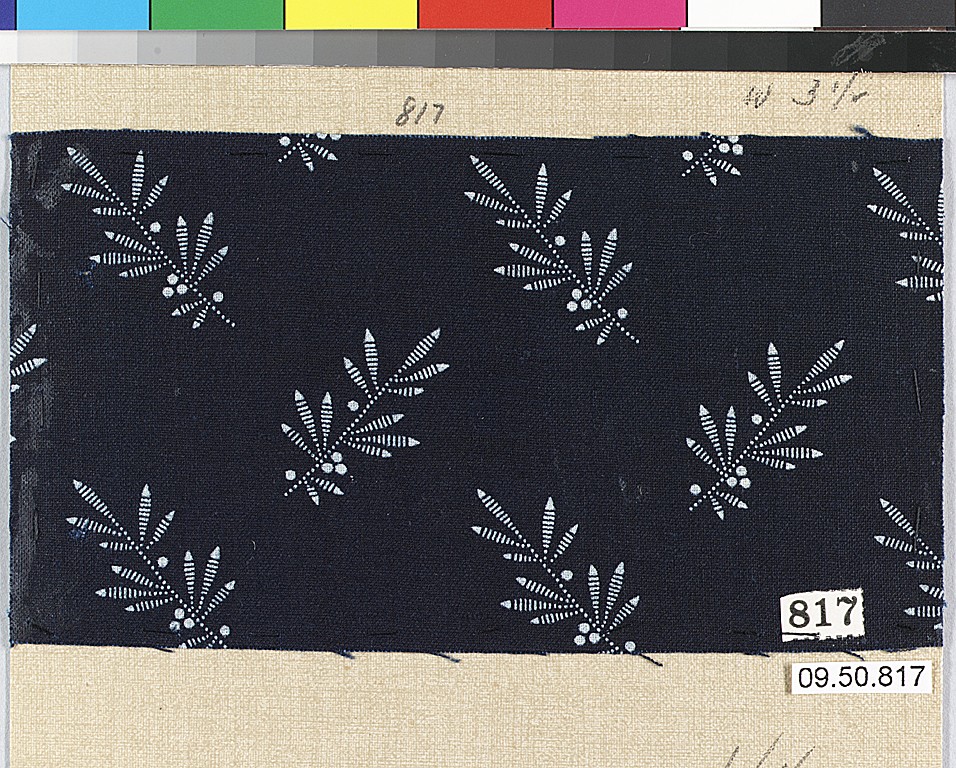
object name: piece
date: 1801-1900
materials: cotton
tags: leaves